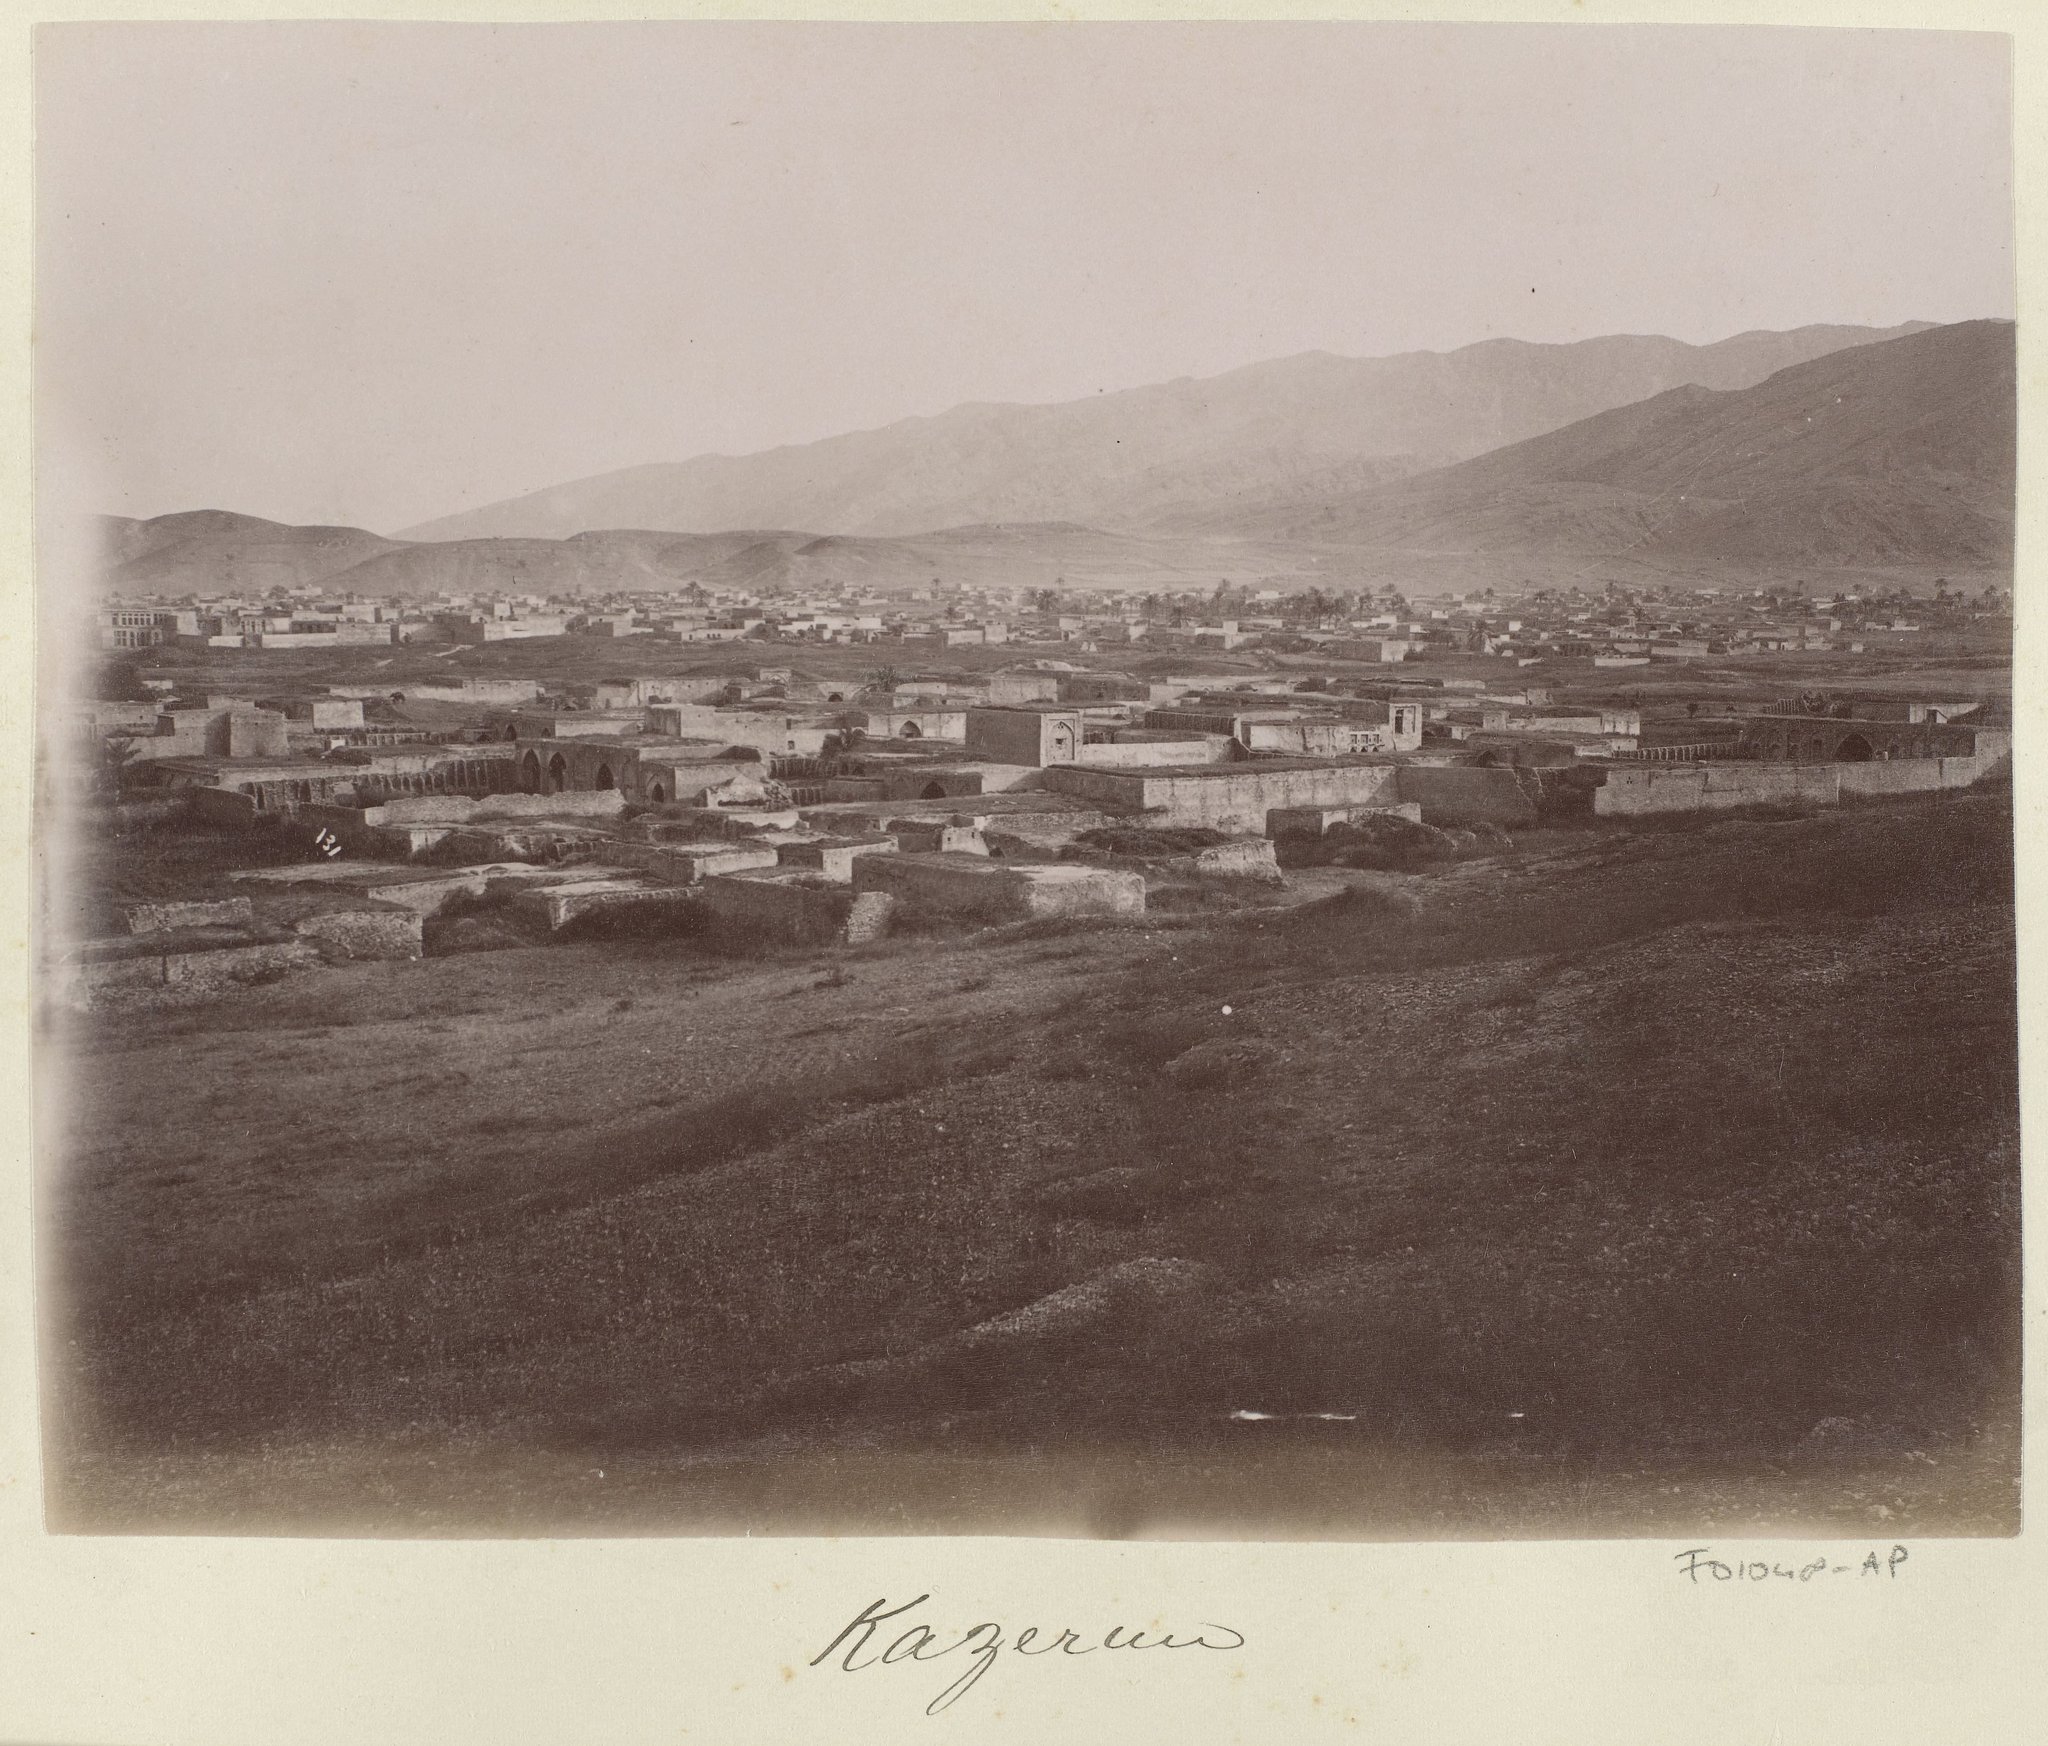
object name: photograph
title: Kazerun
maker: antoine sevruguin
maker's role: fotograaf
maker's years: 1840-1933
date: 1880-1895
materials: paper, photographic support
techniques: albumen print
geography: kazerun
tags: mountains (+ landscape with figures, staffage)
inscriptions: negative number: ‘131’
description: Onderdeel van Reisalbum van H. Dunlop met foto's van bezienswaardigheden in Perzië, Schotland, Duitsland, Rusland, China en Canada.